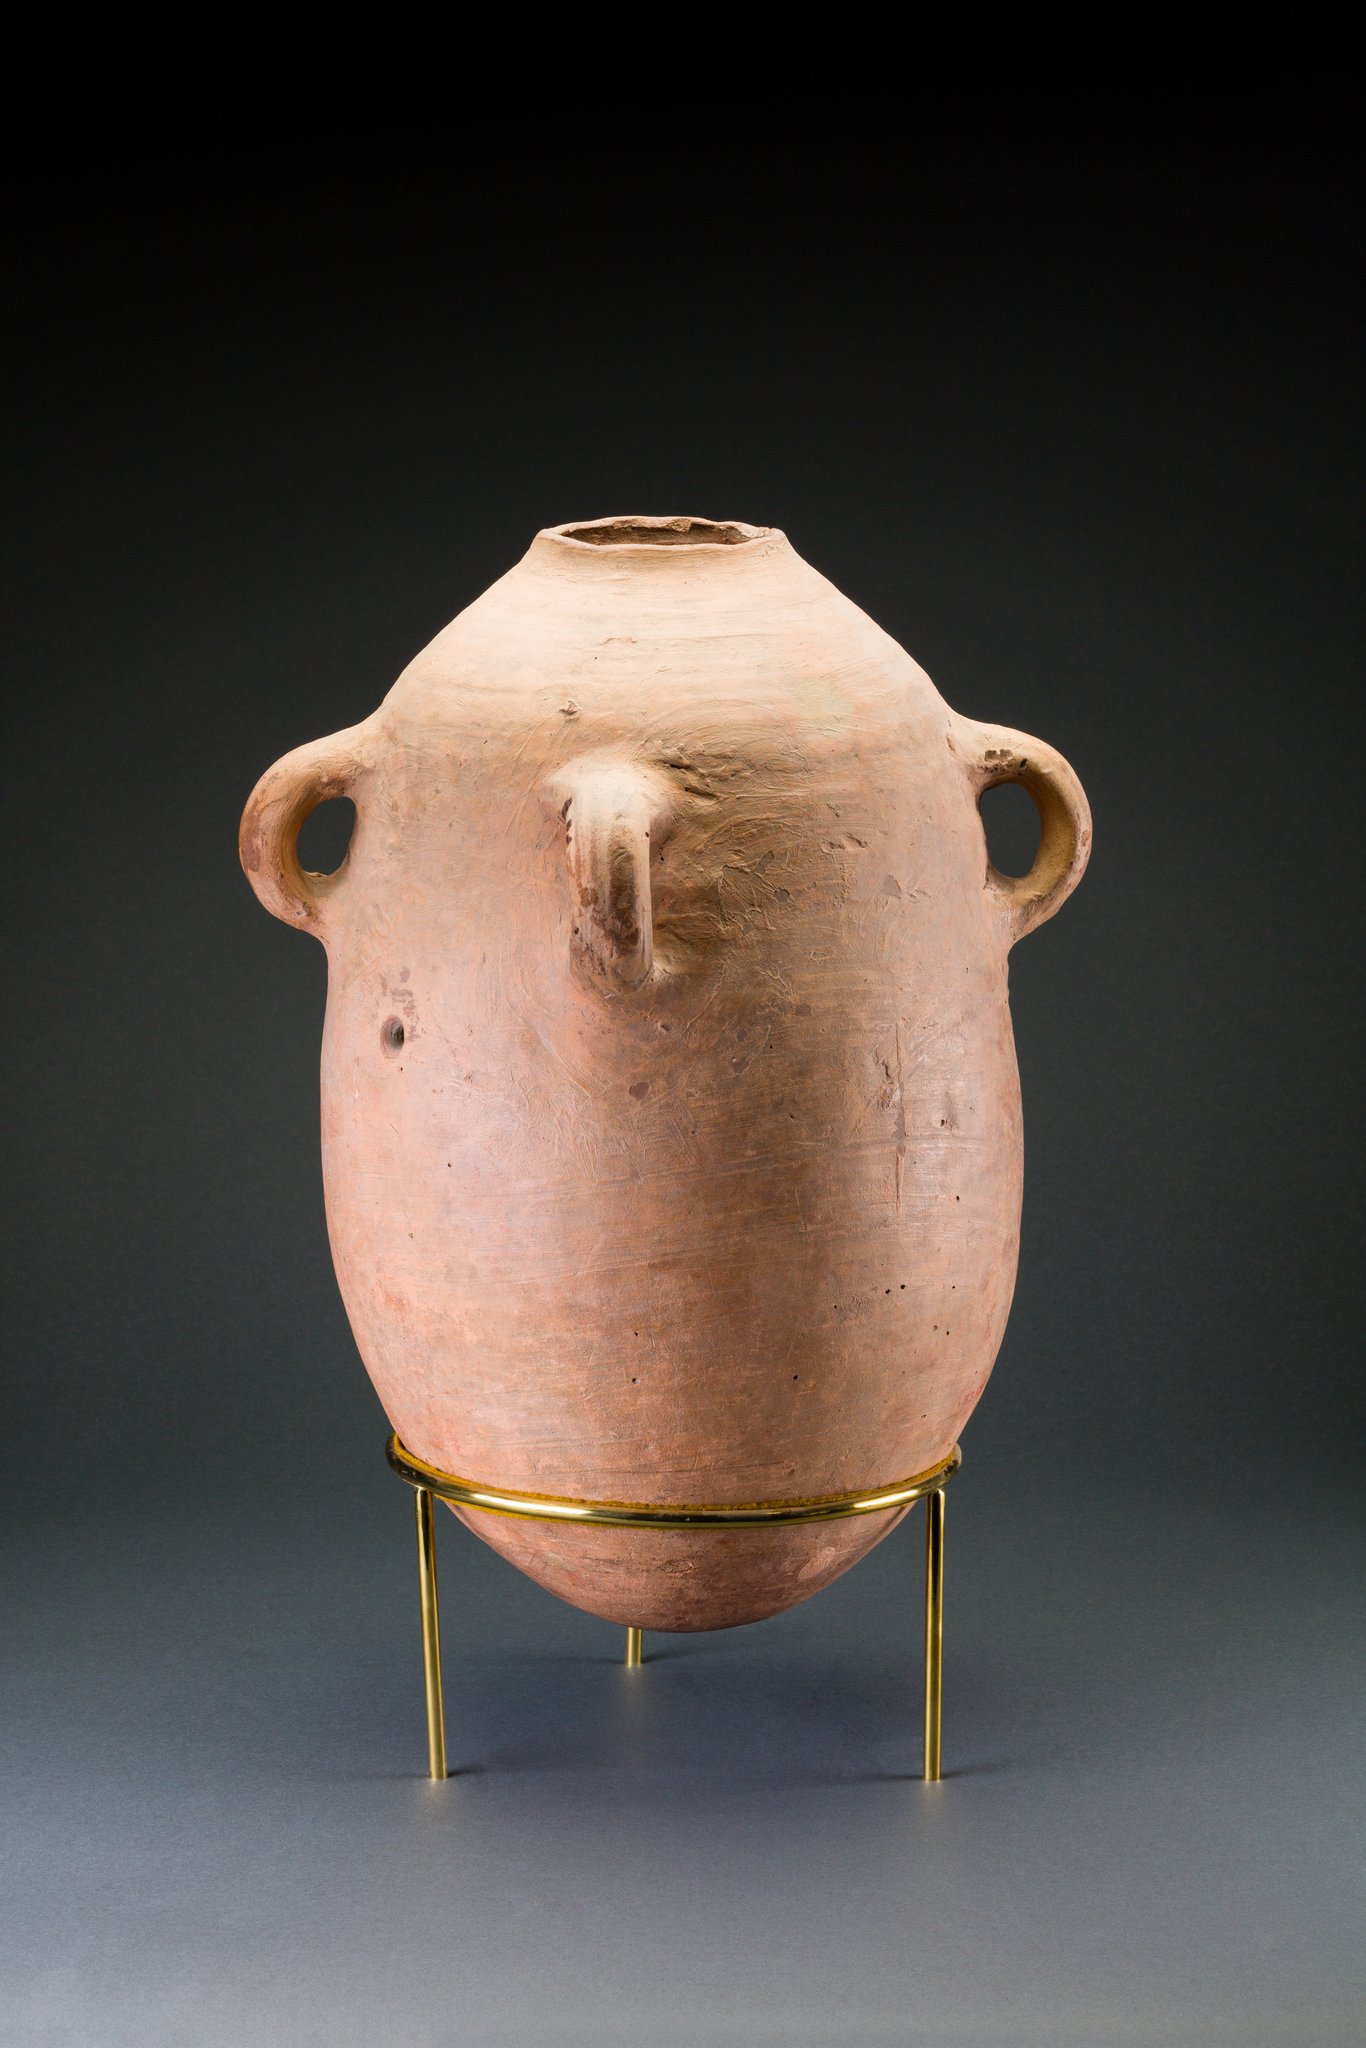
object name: jar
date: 1550-1295 BCE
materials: pottery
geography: egypt